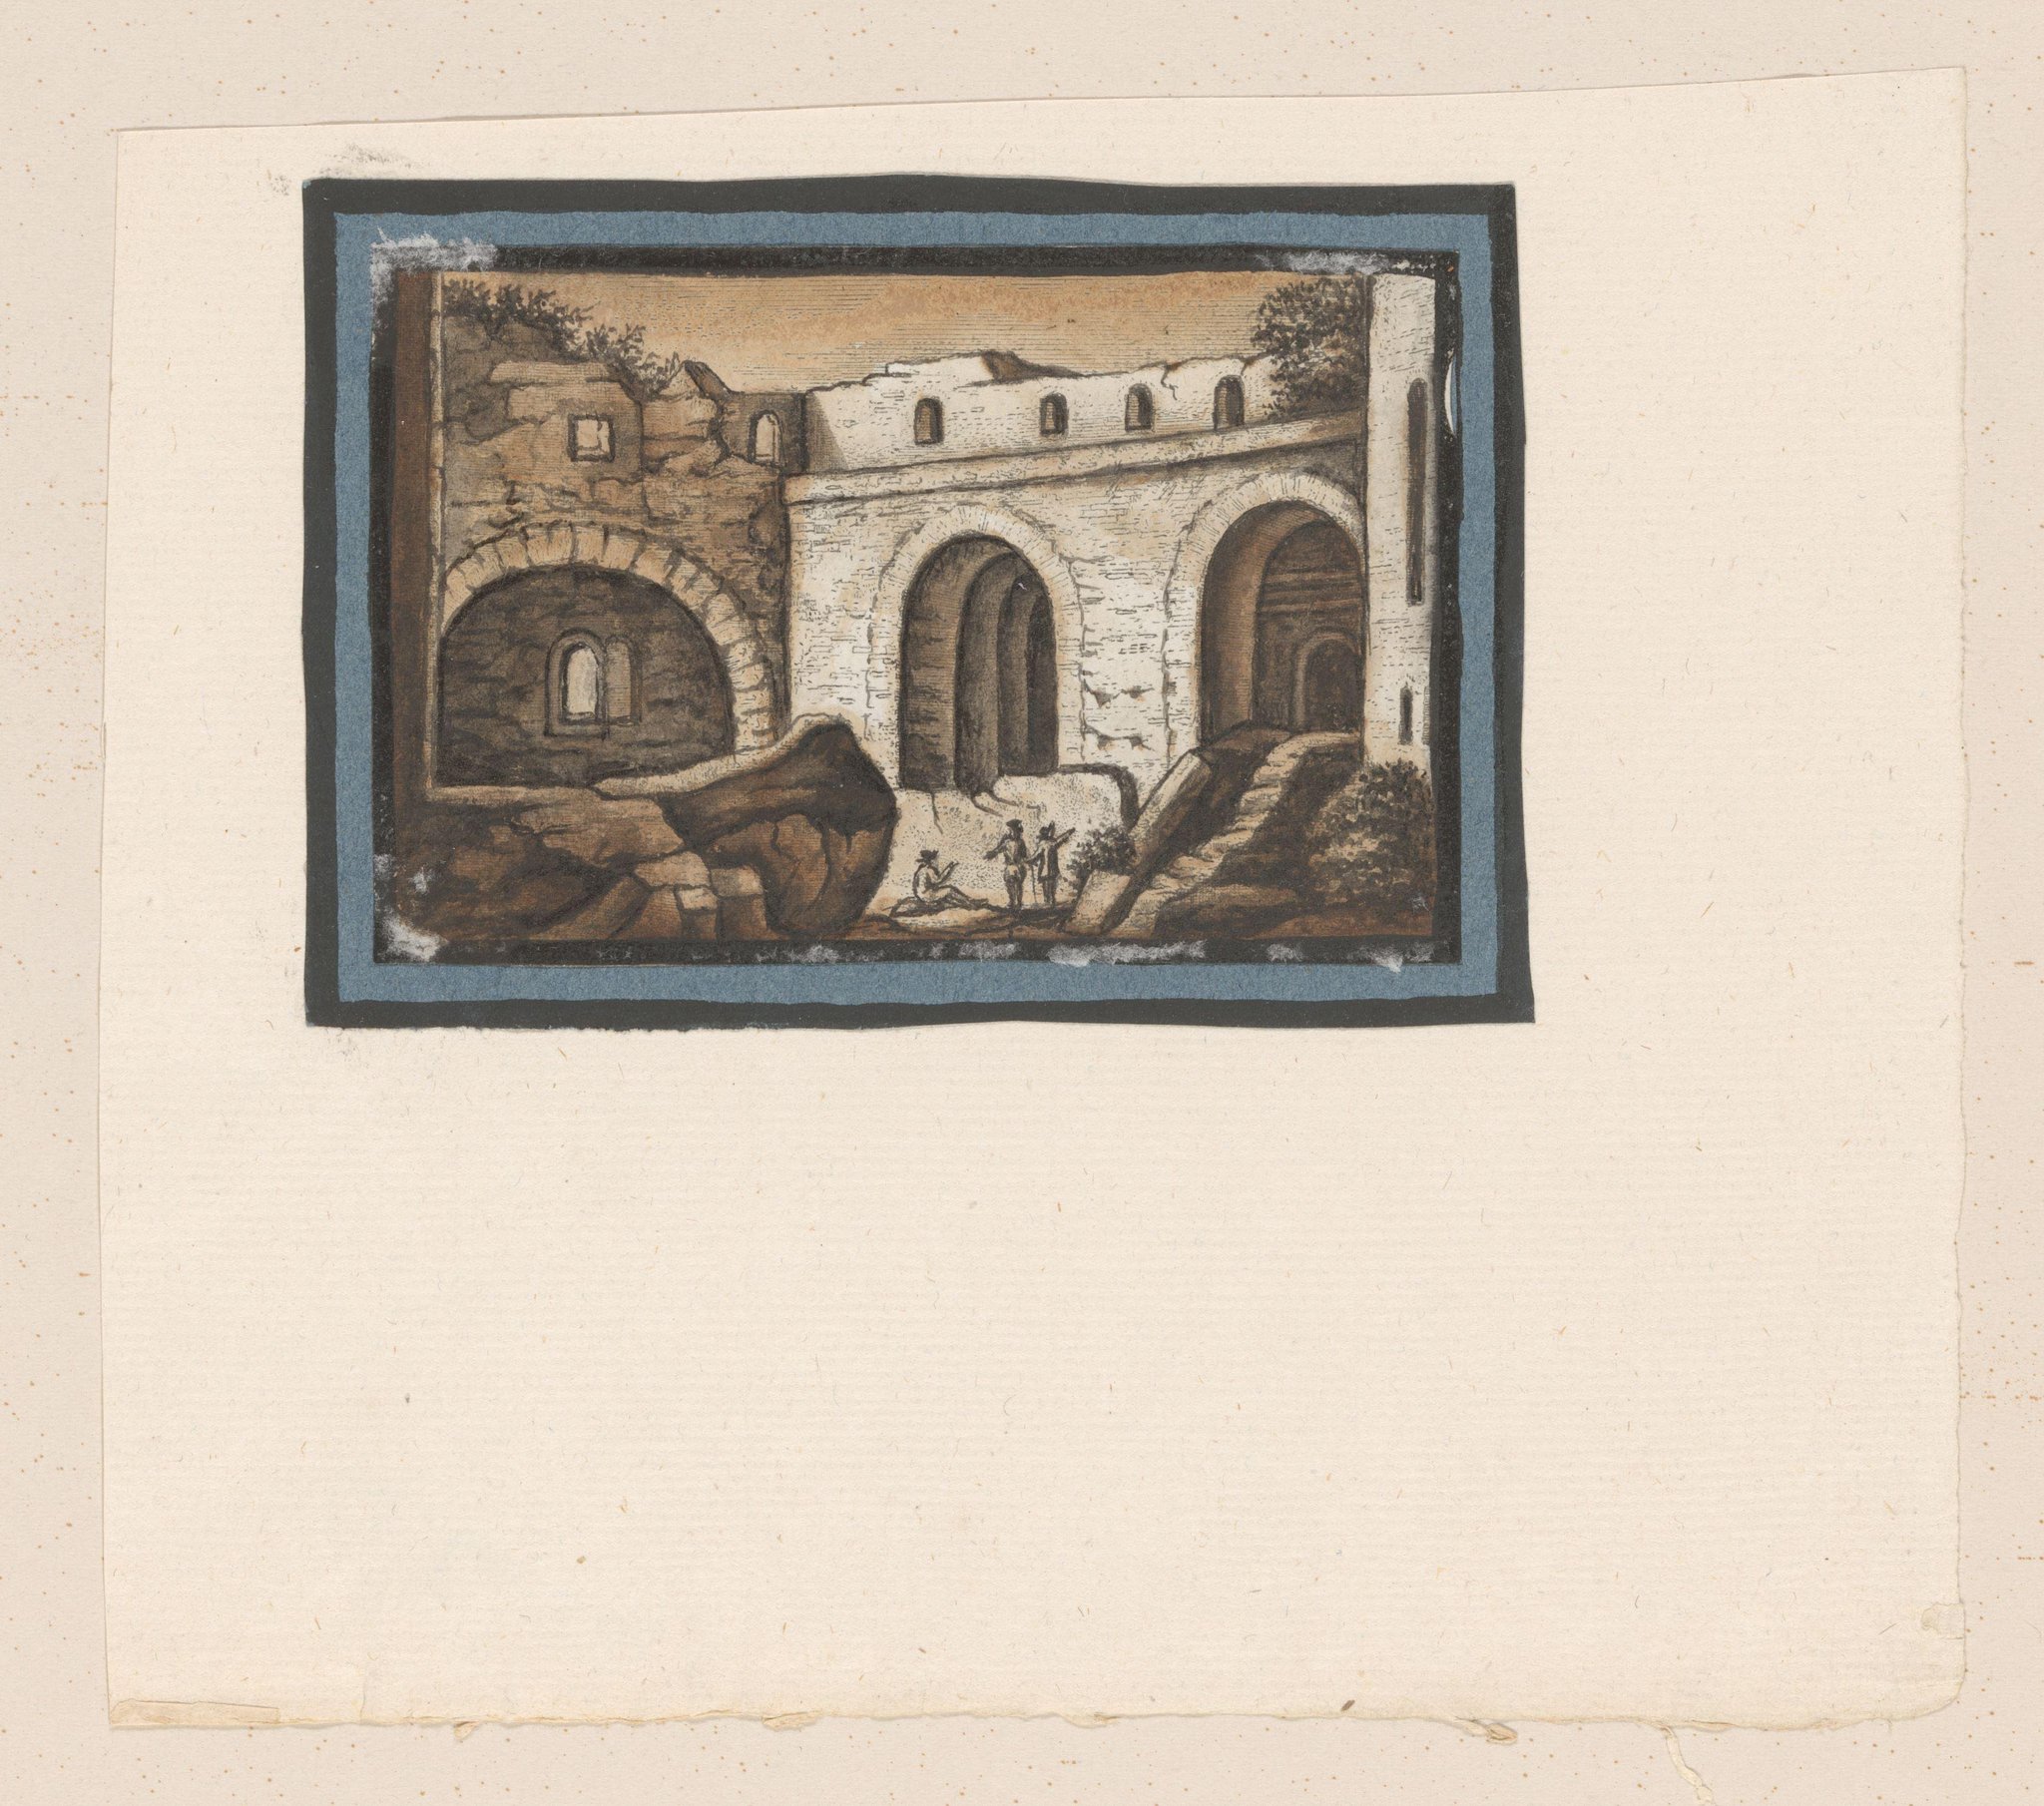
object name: print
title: Gezicht op de binnenzijde van Slot Abcoude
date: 1725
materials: ink, paper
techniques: brush, etching, hand coloring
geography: amsterdam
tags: castle, landscape with tower or castle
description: Een ingekleurd exemplaar van een spiegelbeeldige kopie van de prent zoals die voorkomt als nr. 246 in: Rademaker, Abraham. Kabinet van Nederlandsche outheden en gezichten (...). Amsterdam: Willem Barents, 1725.